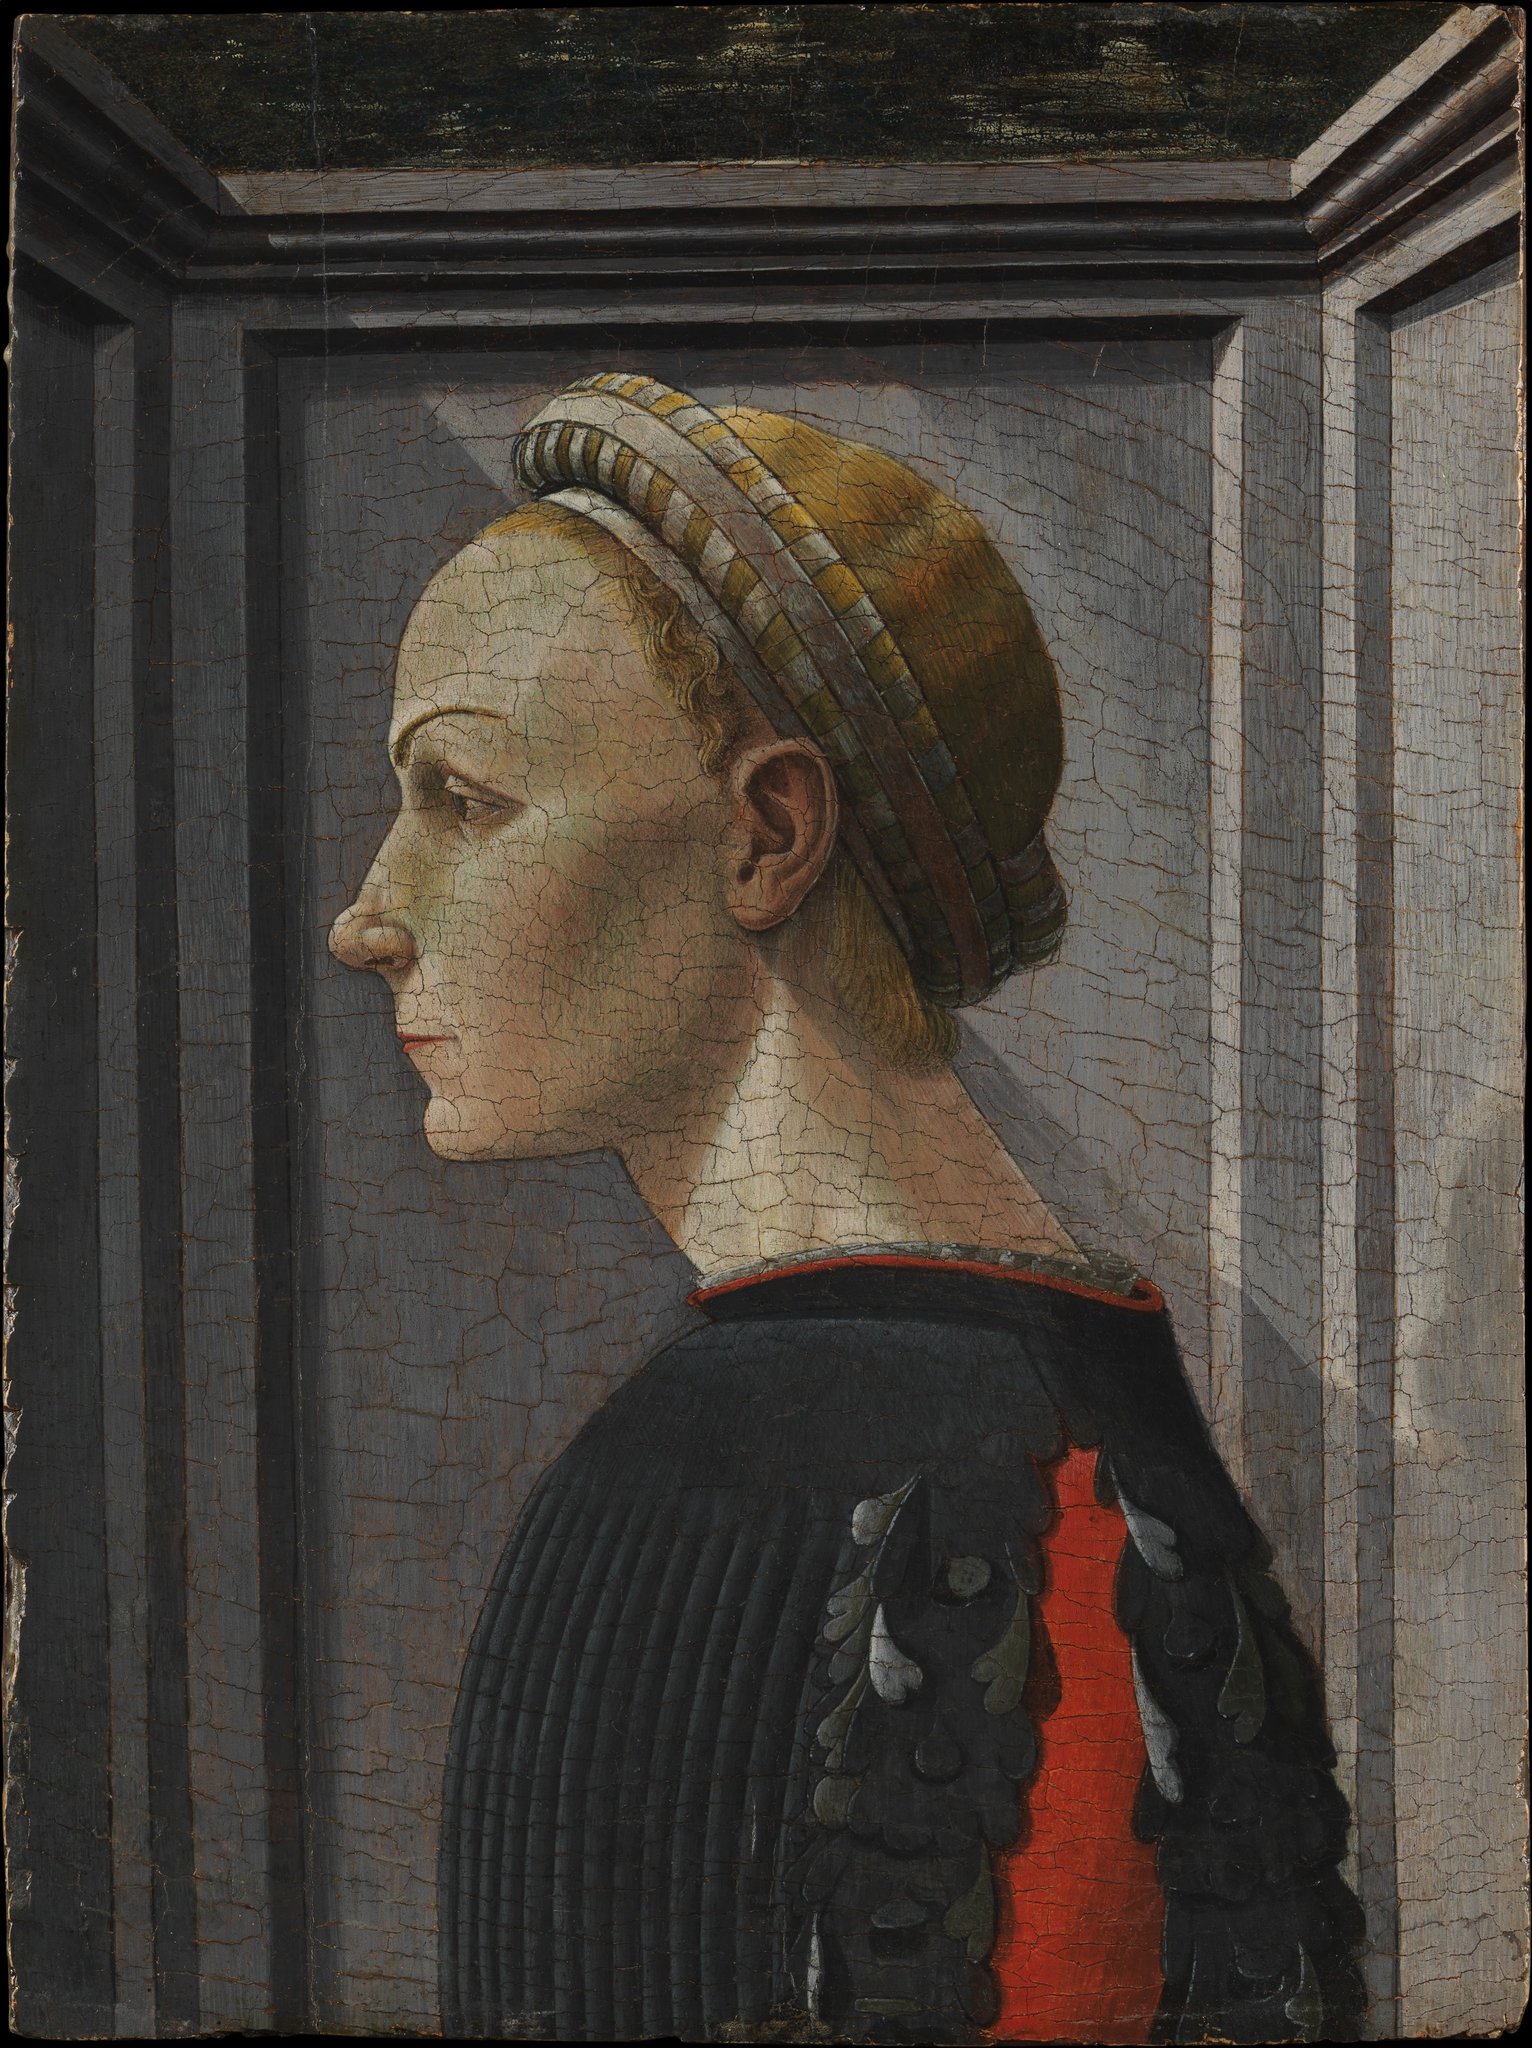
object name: painting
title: Portrait of a Woman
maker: giovanni di francesco del cervelliera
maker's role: artist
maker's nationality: italian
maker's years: 1412-1459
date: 1445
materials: paint, wood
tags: portraits,profiles,women